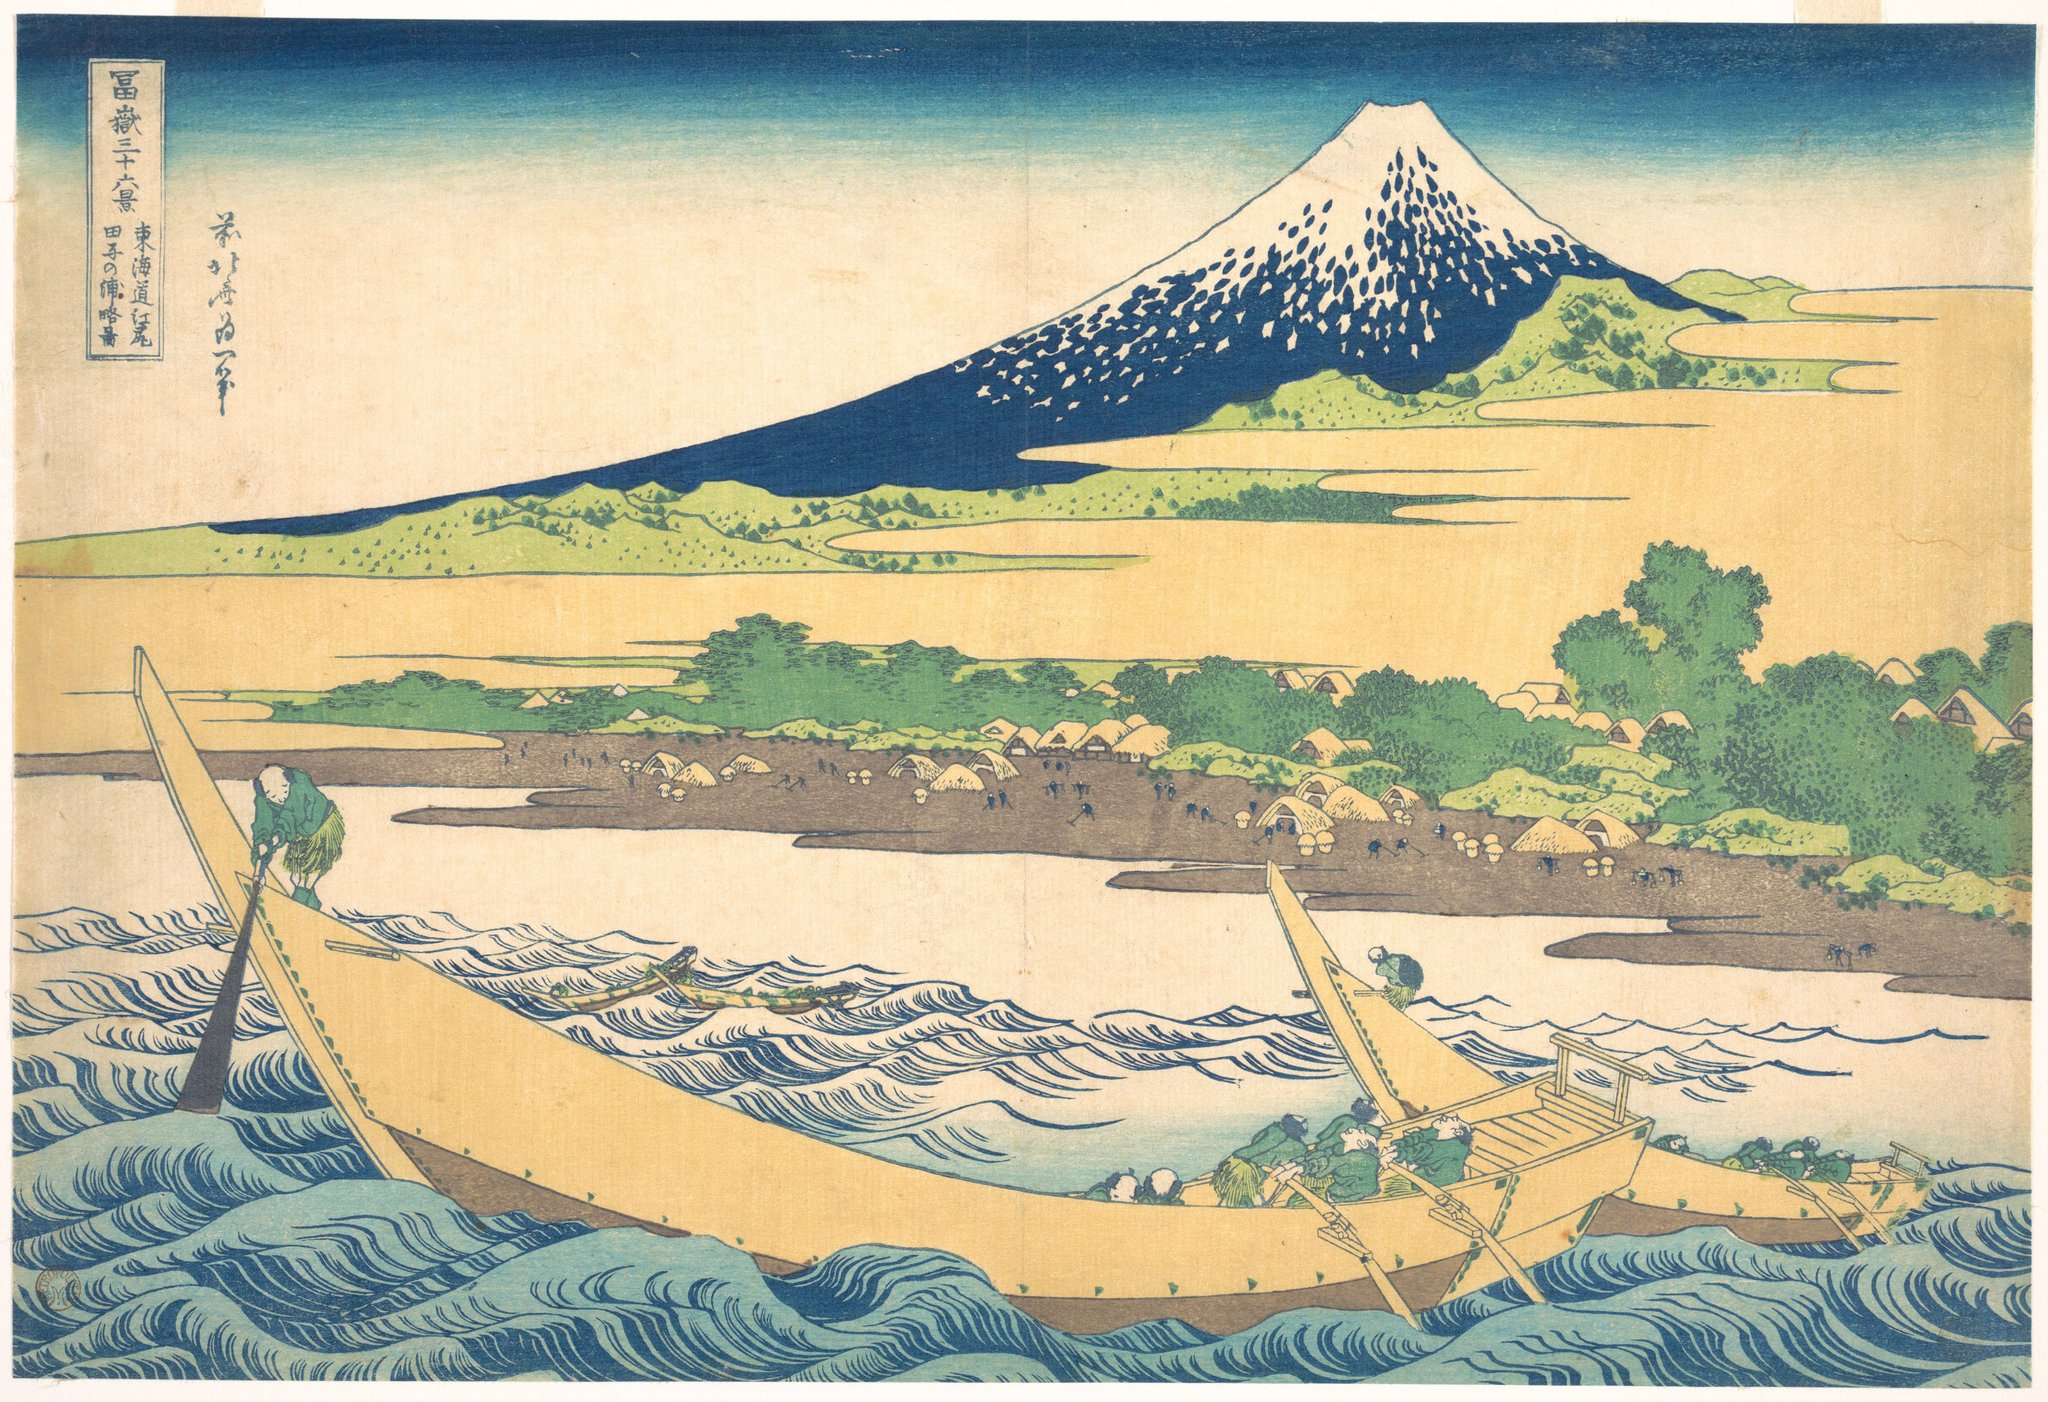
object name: woodblock print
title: Tago Bay near Ejiri on the Tōkaidō (Tōkaidō Ejiri Tago no ura ryaku zu), from the series Thirty-six Views of Mount Fuji (Fugaku sanjūrokkei)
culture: japanese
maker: katsushika hokusai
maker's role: artist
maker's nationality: japanese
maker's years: 1760-1849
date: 1830-1832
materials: ink, paper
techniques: woodblock print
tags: men,mountains,seascapes,boats